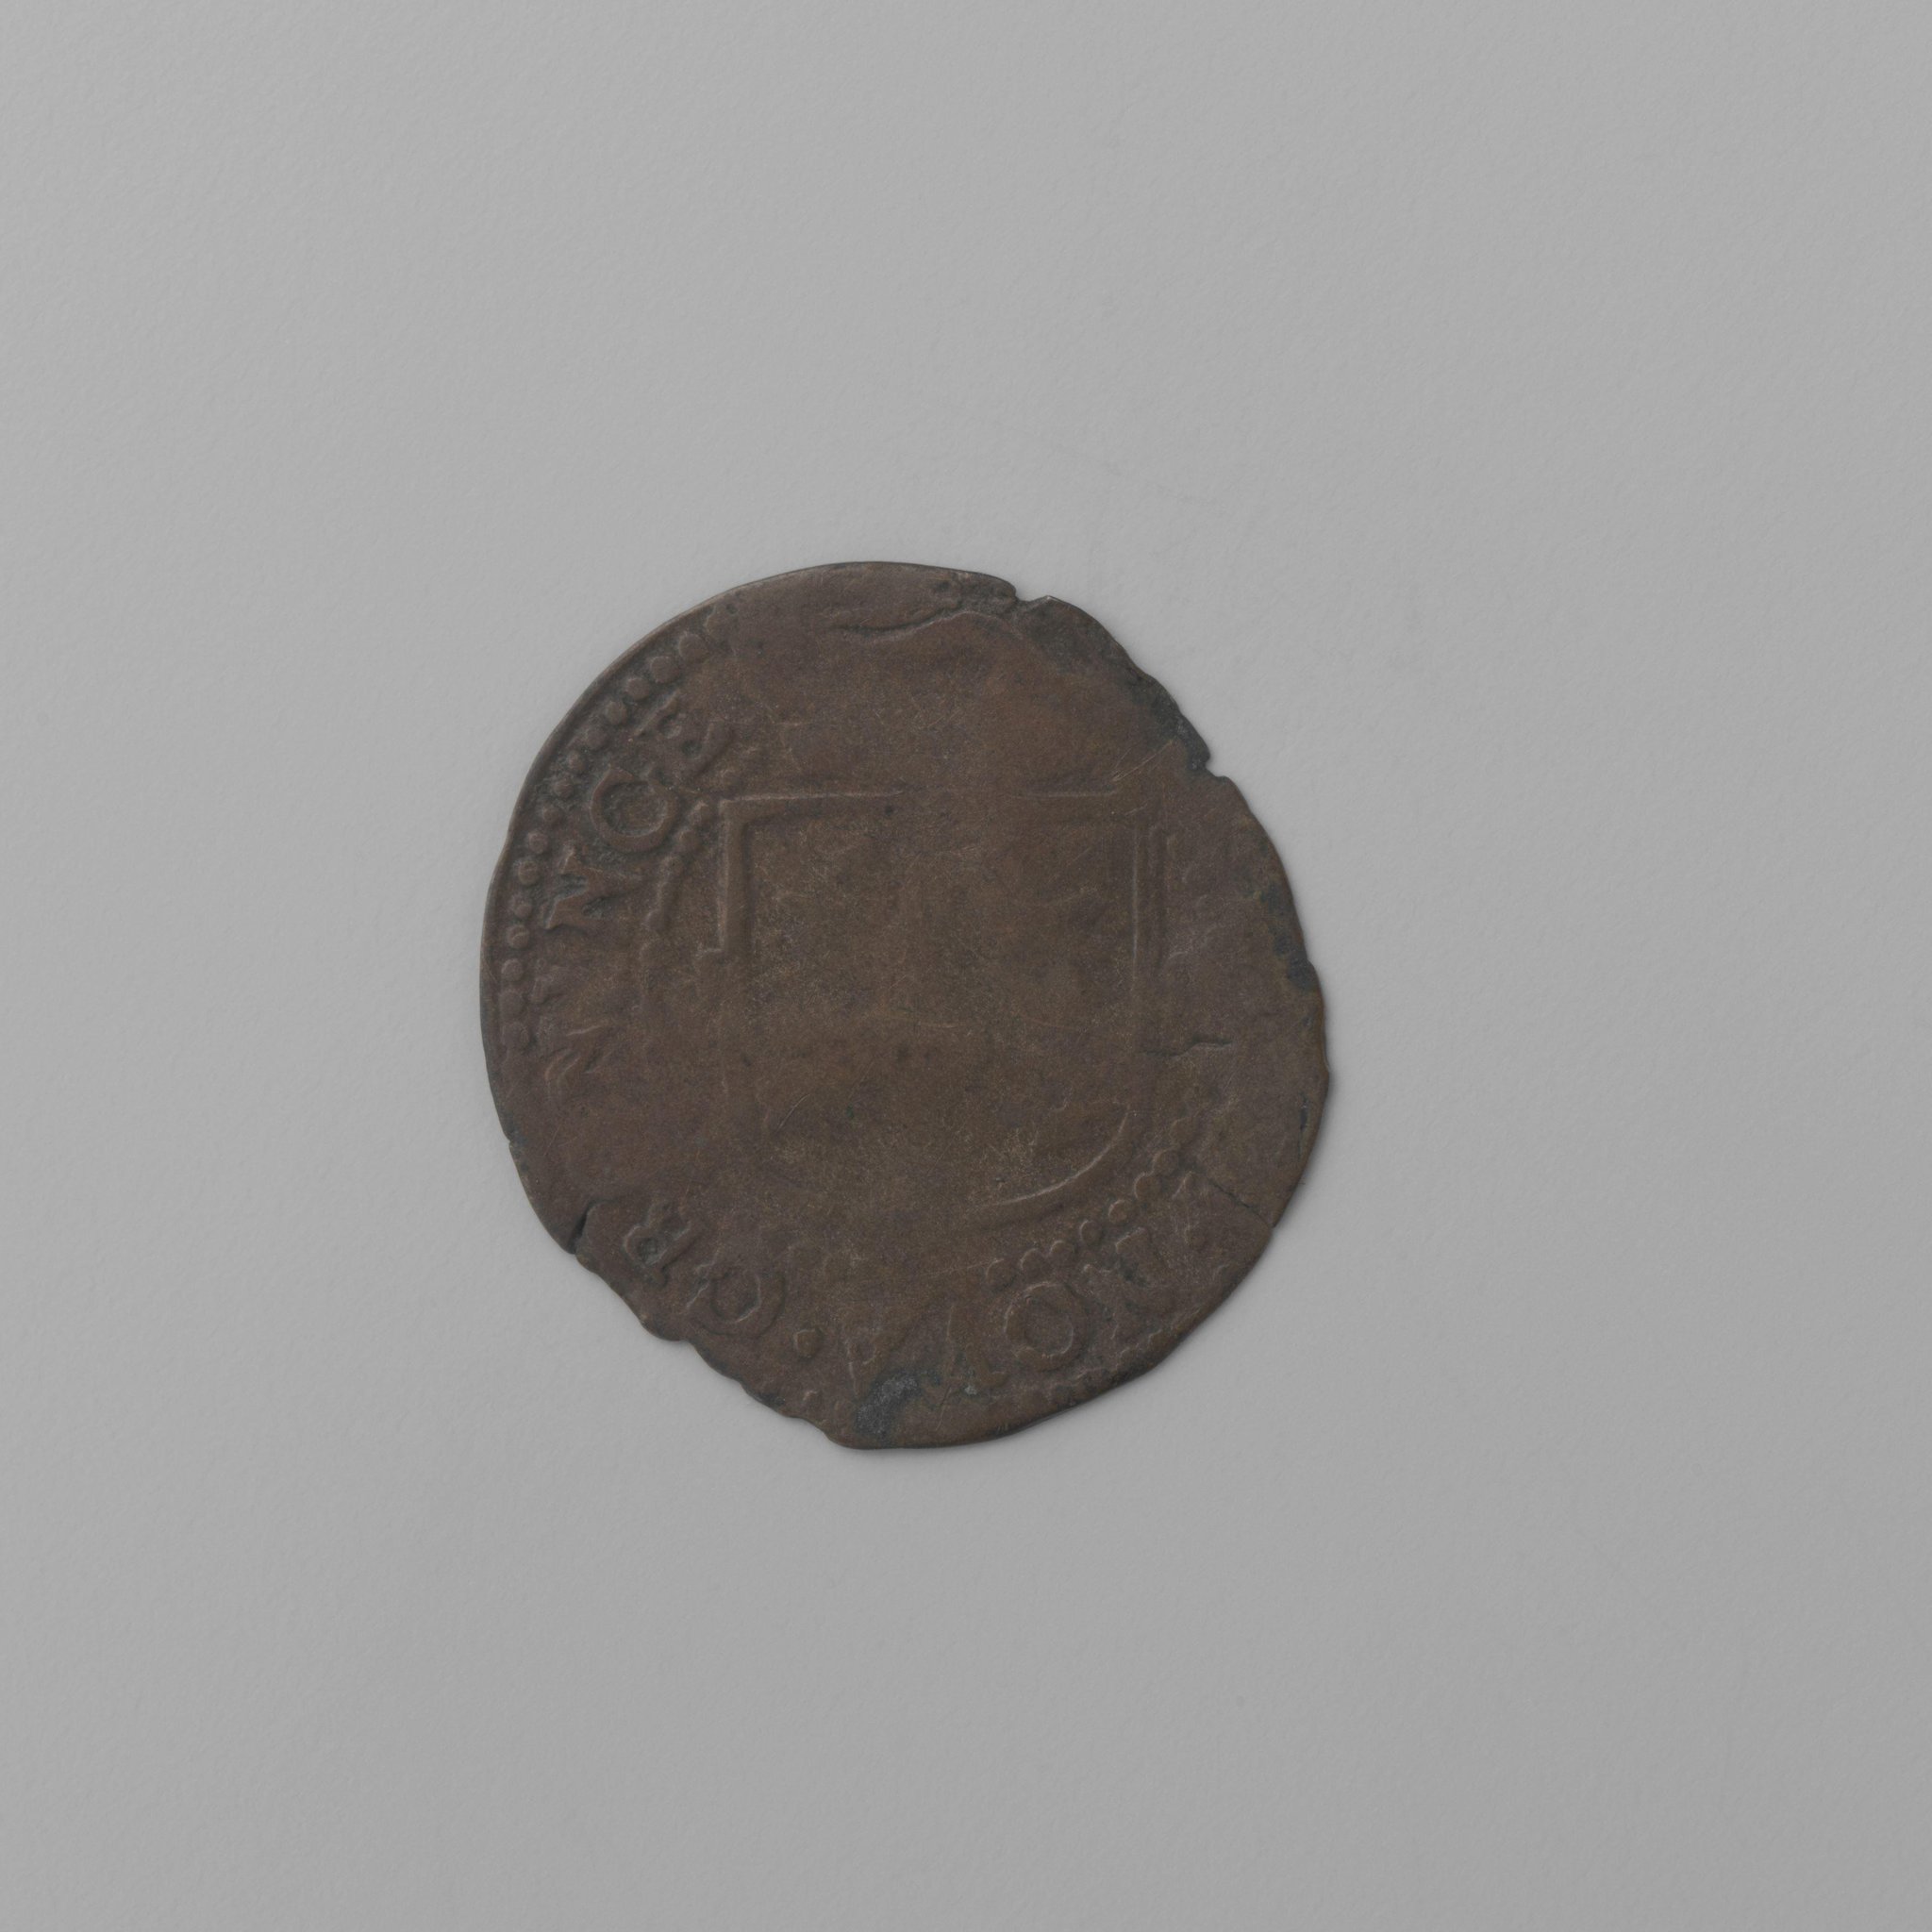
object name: coin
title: Groningen, halve stuiver Brabants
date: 1604-1649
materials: copper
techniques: striking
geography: groningen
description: Zilveren munt. Voorzijde: tussen waarde-aanduiding ½ S gekroond wapenschild. Keerzijde: lang gebloemd kruis, in de hoeken de letters S,P,Q en G, in het hart wapenschild.